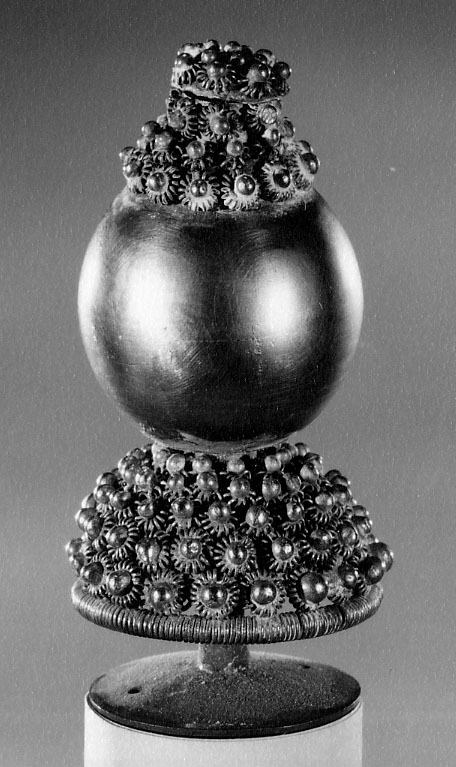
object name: hat finial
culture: chinese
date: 1901-1933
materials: brass